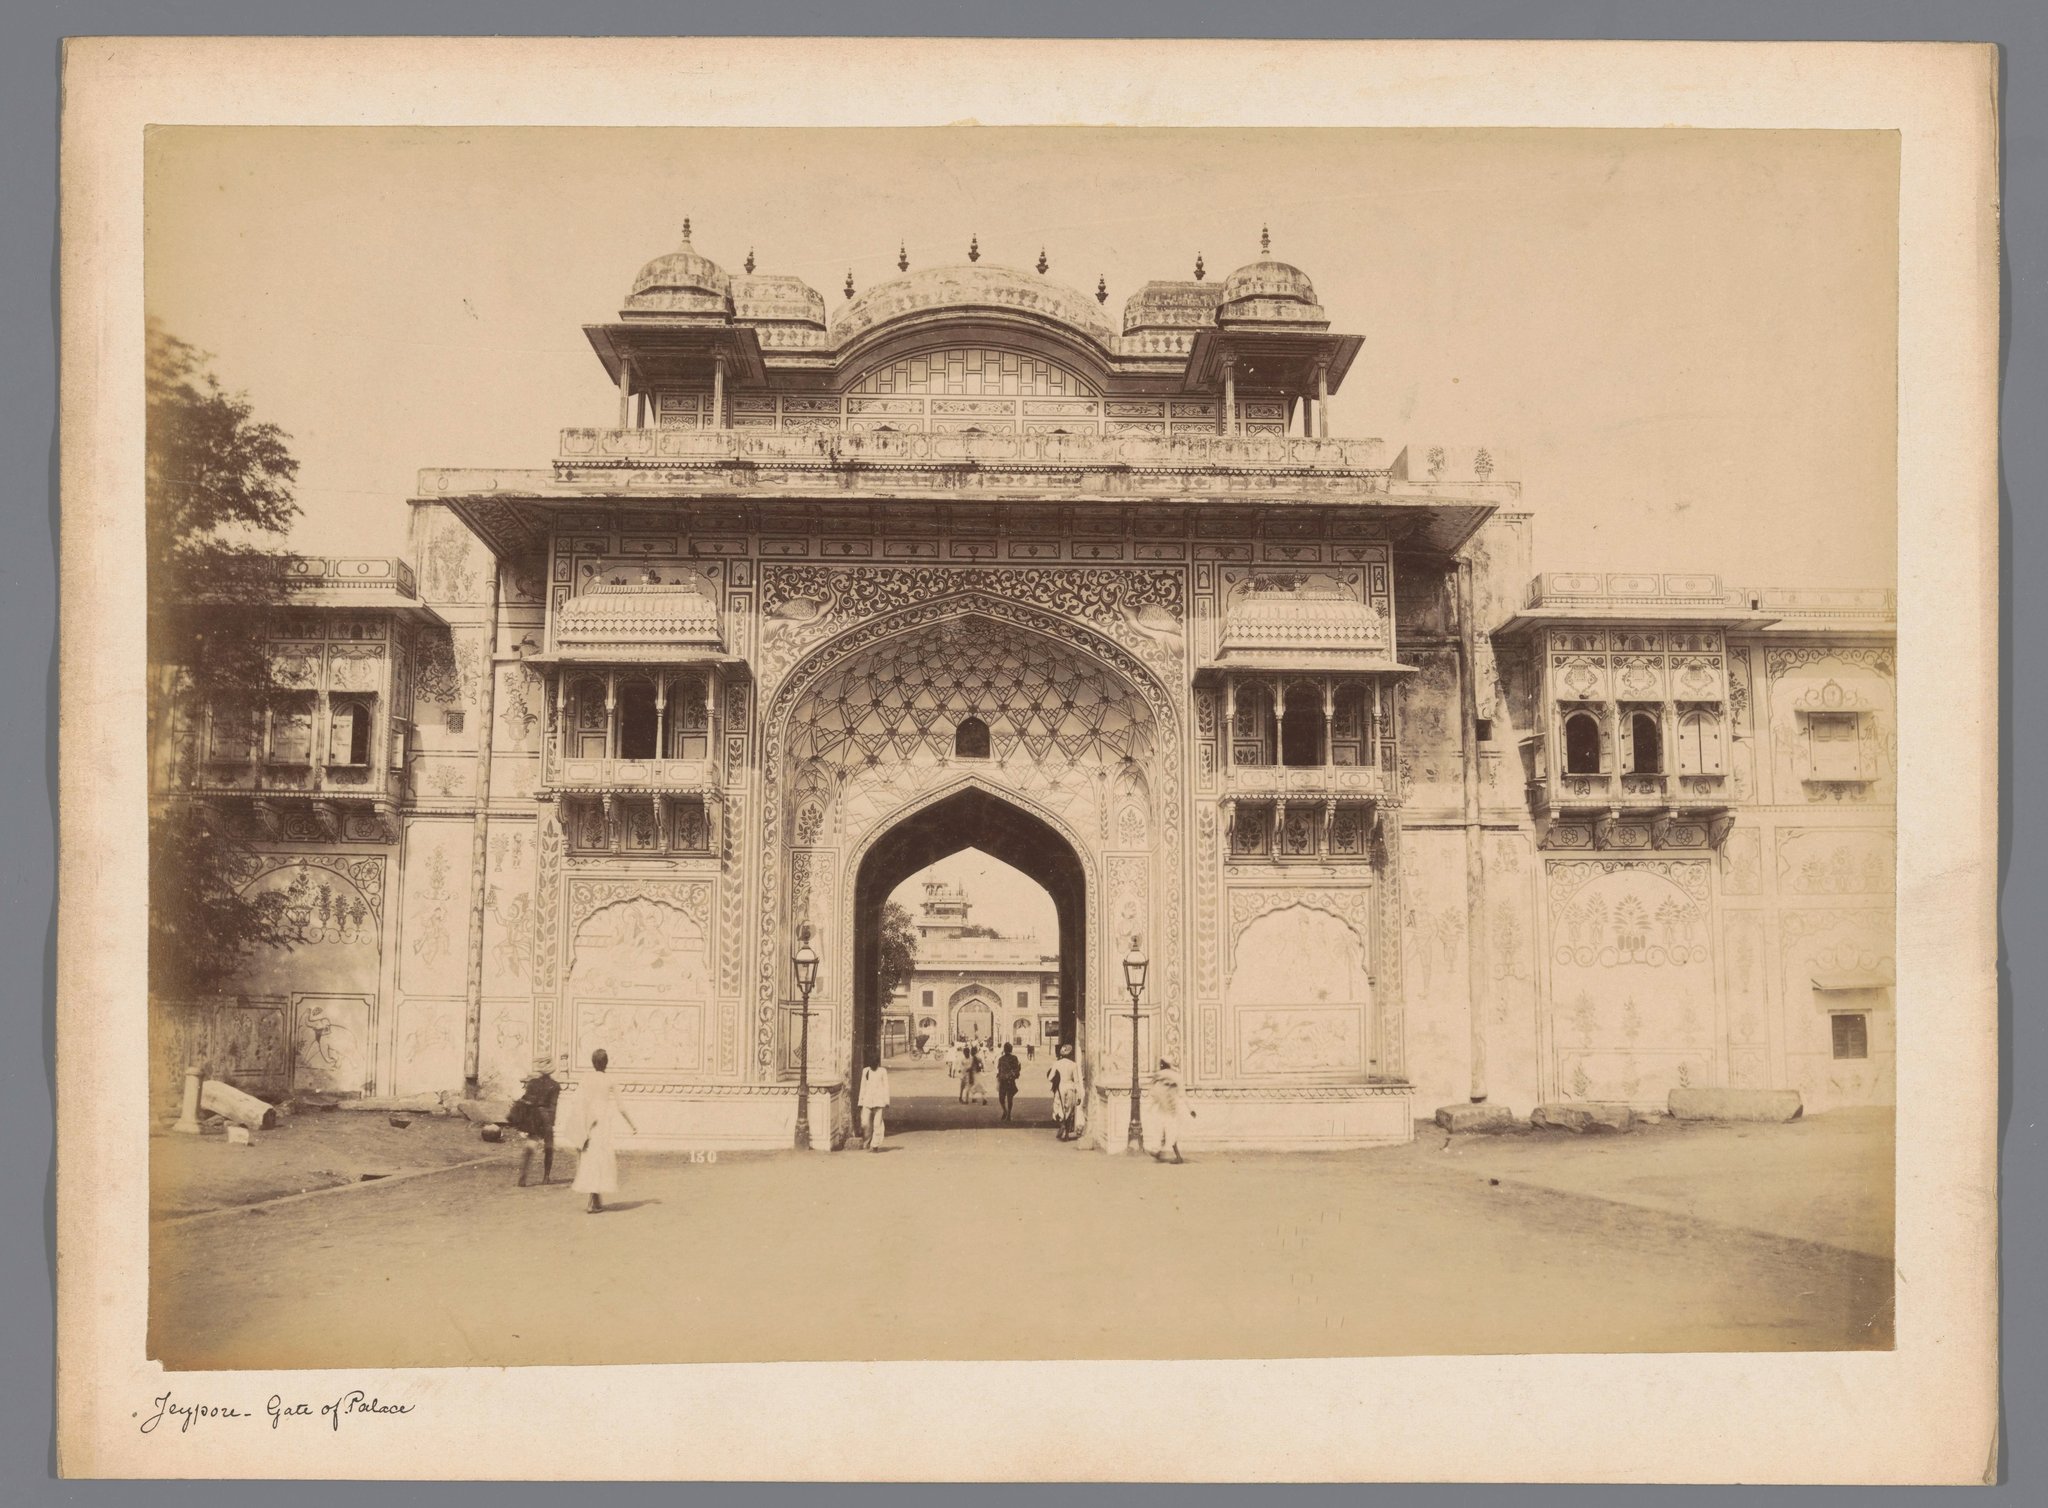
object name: photograph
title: Palace portal in Jaipur, Rajasthan, India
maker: Anonymous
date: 1865-1890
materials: cardboard, paper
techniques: albumen print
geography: jaipur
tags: gate, entrance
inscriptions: number: ‘150’, number: ‘08’, title: ‘Jeypore - Gate of Palace’